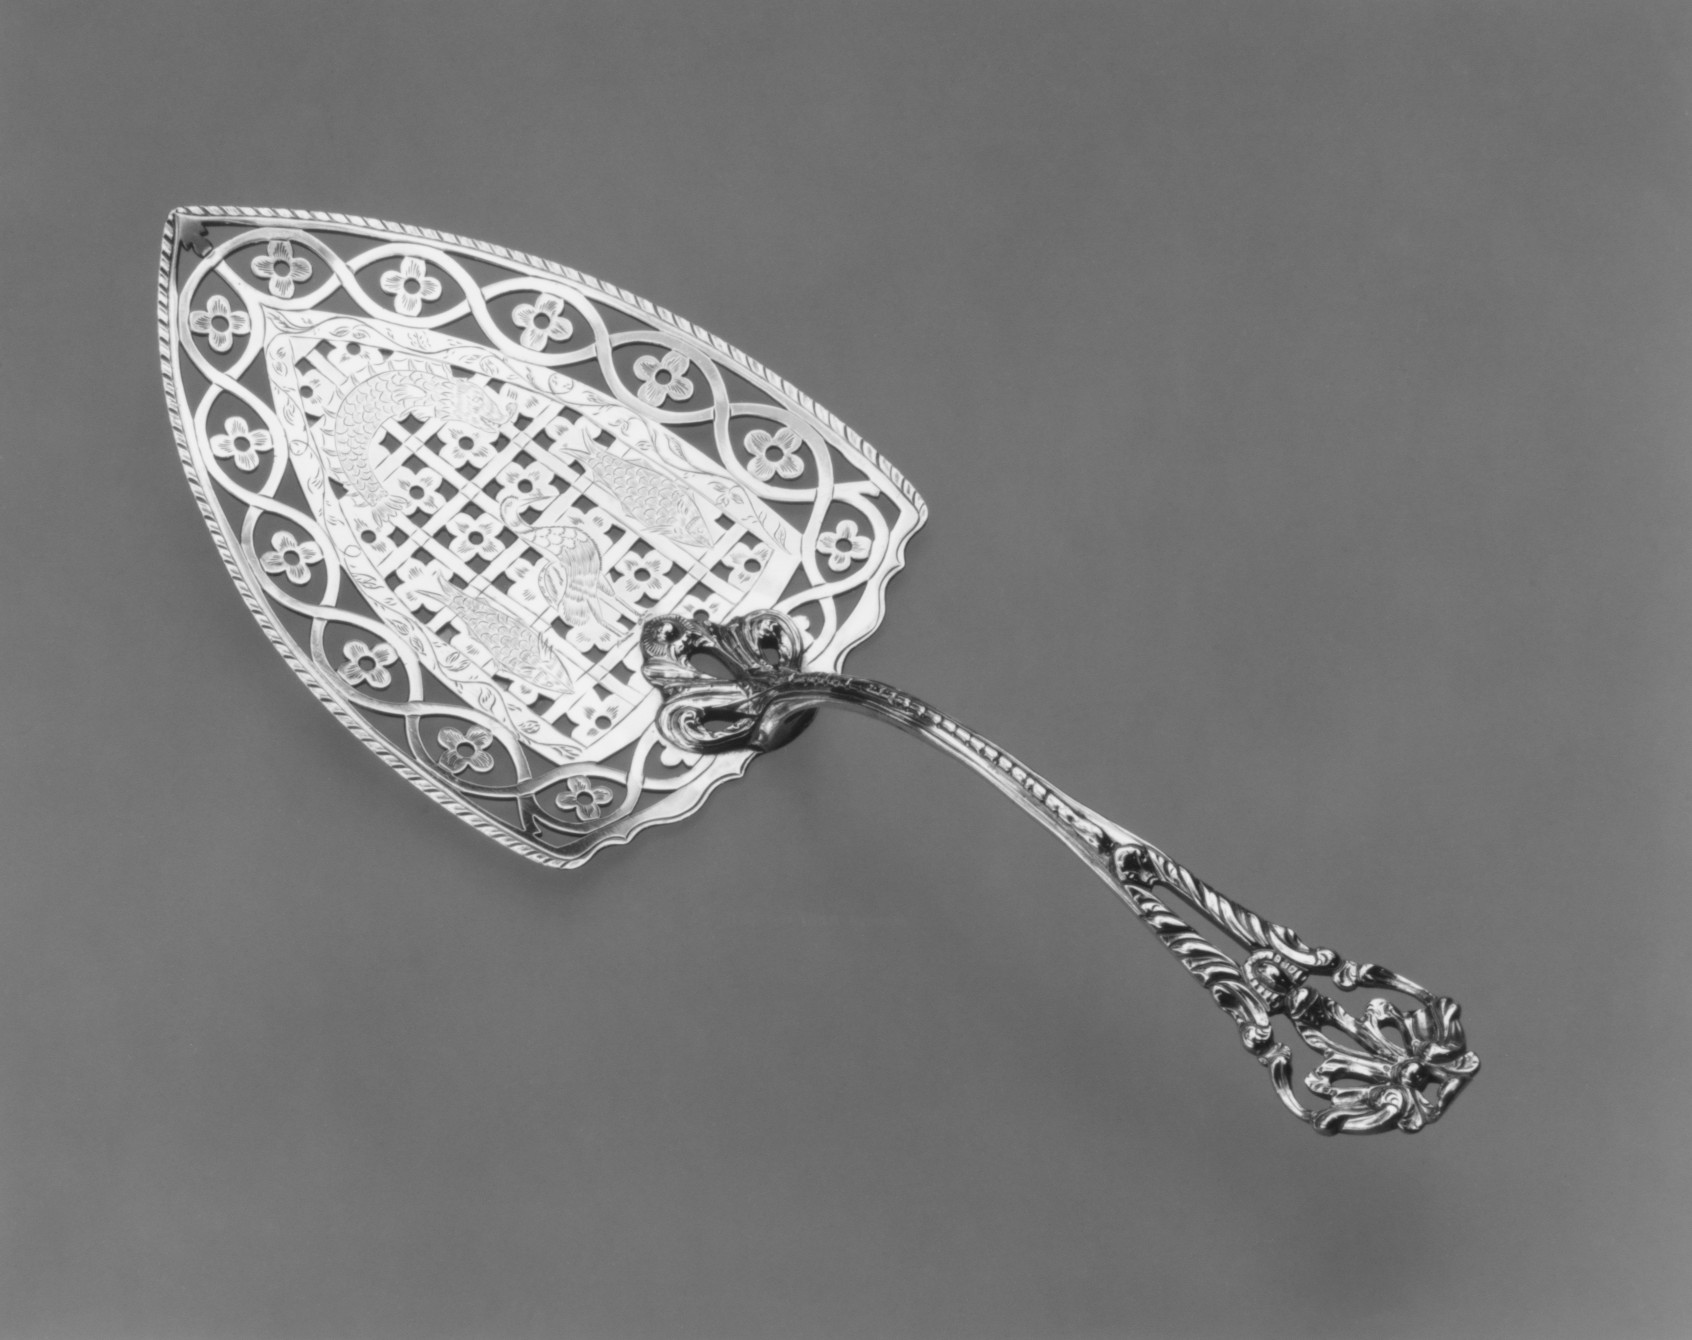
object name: fish slice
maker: charles aldridge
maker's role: maker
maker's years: 1775-1793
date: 1772-1773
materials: silver